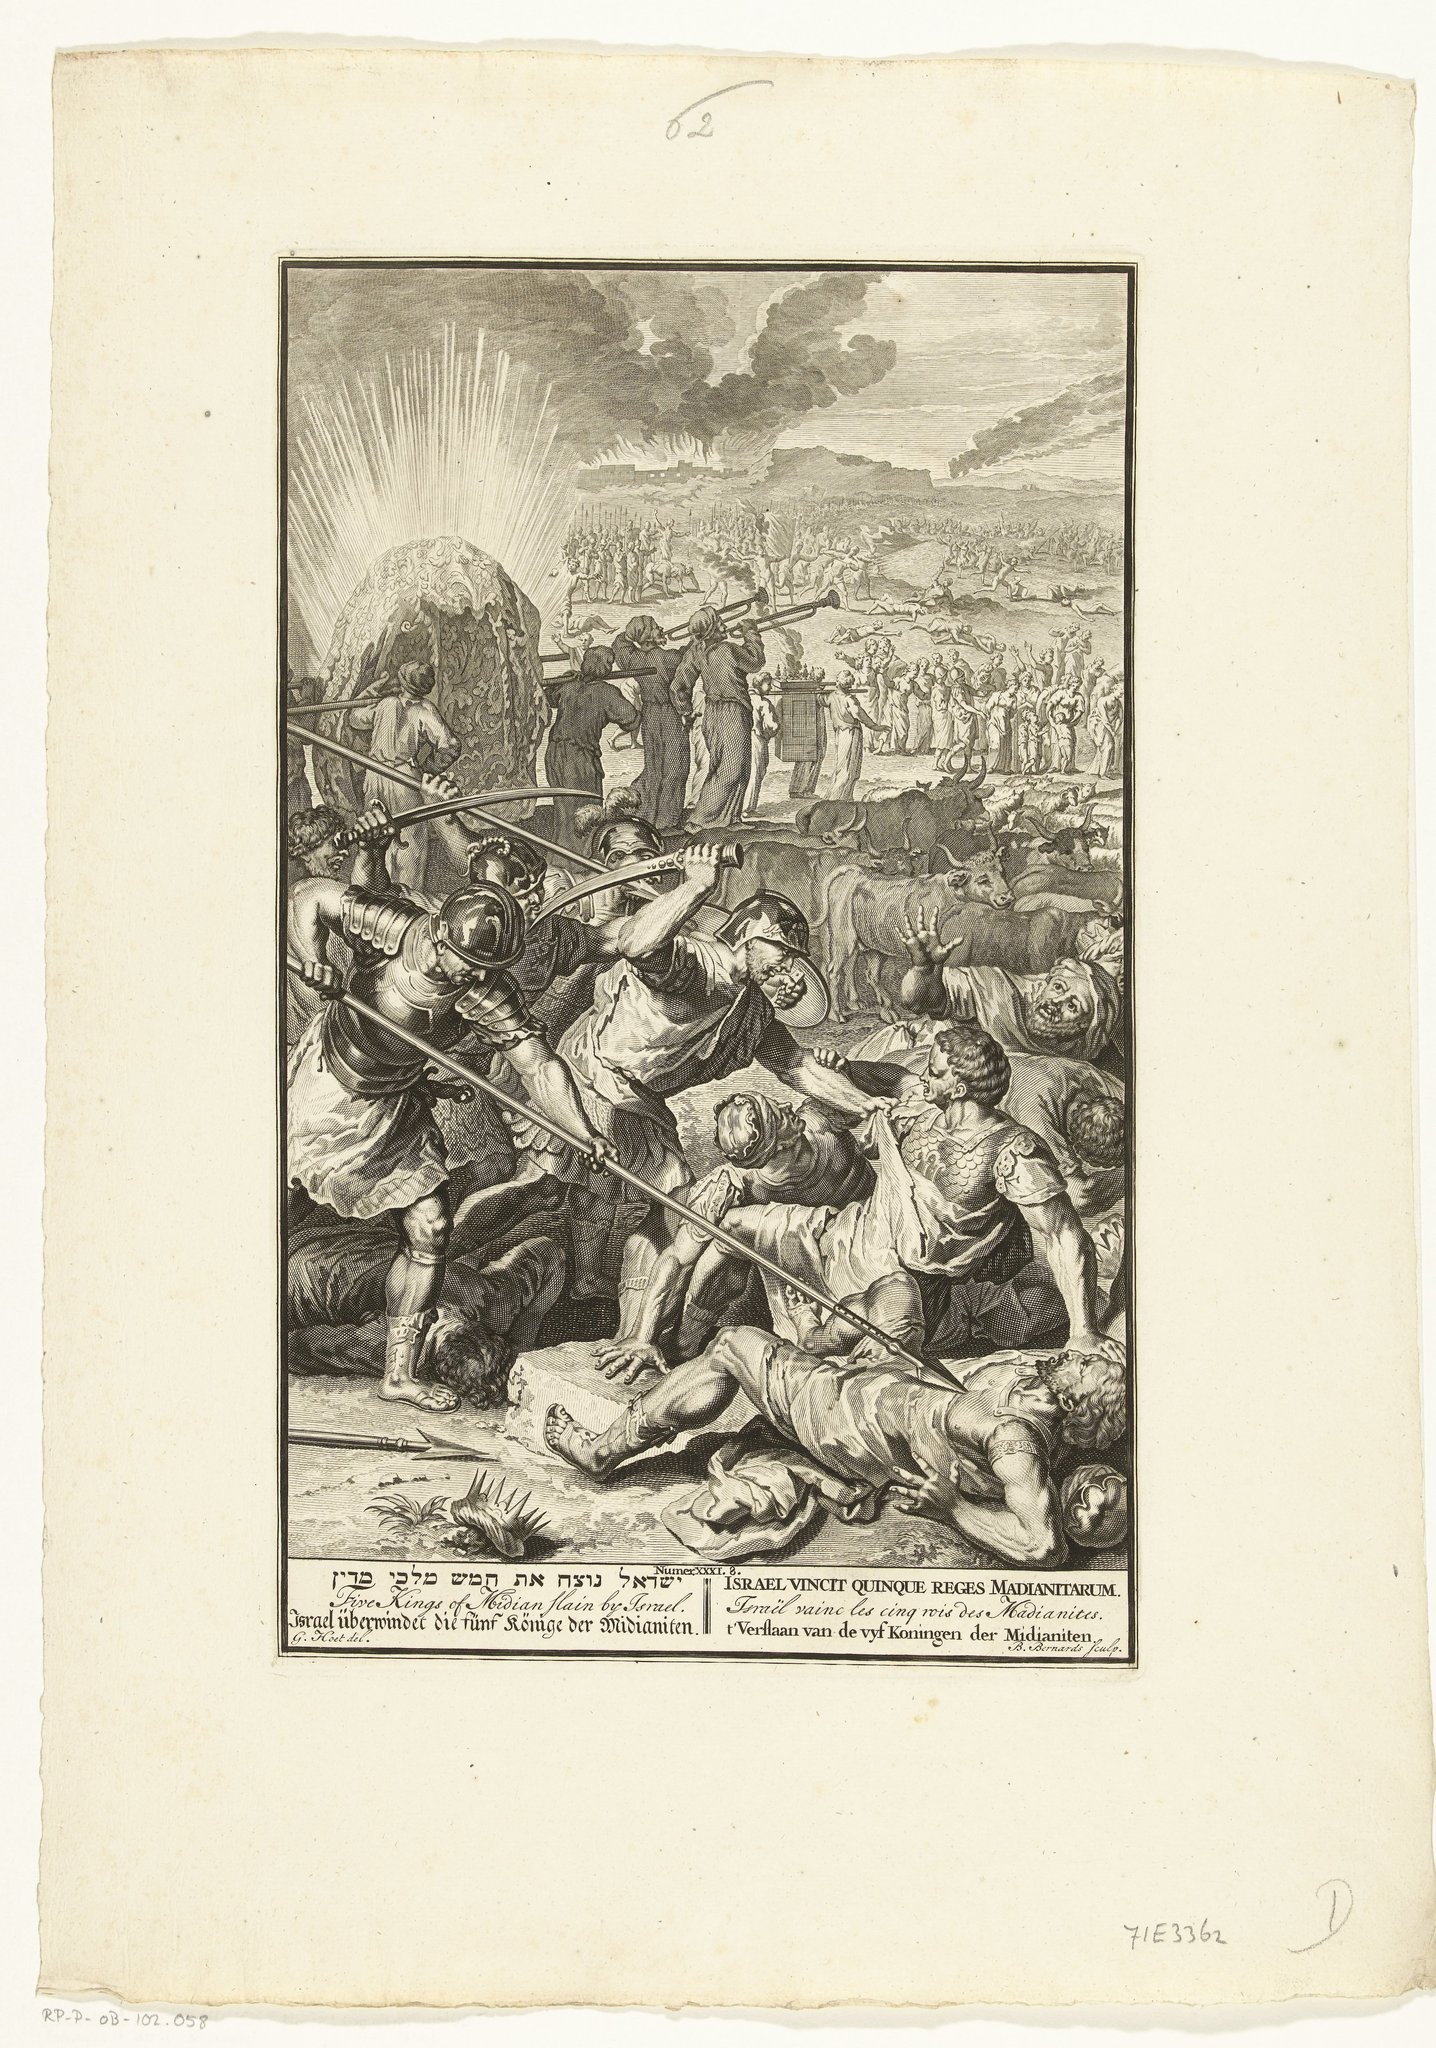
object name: book illustration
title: Slag tegen de Midjanieten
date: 1720-1728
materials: paper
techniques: engraving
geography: amsterdam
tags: all the midianite men, including their five kings and balaam, are killed; the women, children and animals are captured, and the cities are burnt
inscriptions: collector's mark: Lugt 2228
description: Prent gemaakt voor: Figures de la Bible. Amsterdam, Bernard Picart, 1720. Prent ook gebruikt in: Taferelen der voornaamste geschiedenissen van het Oude en Nieuwe Testament (...) door de vermaarde kunstenaars Hoet, Houbraken, en Picart getekent (...) en met beschrijvingen uitgebreid. Den Haag: Pieter de Hondt, 1728.